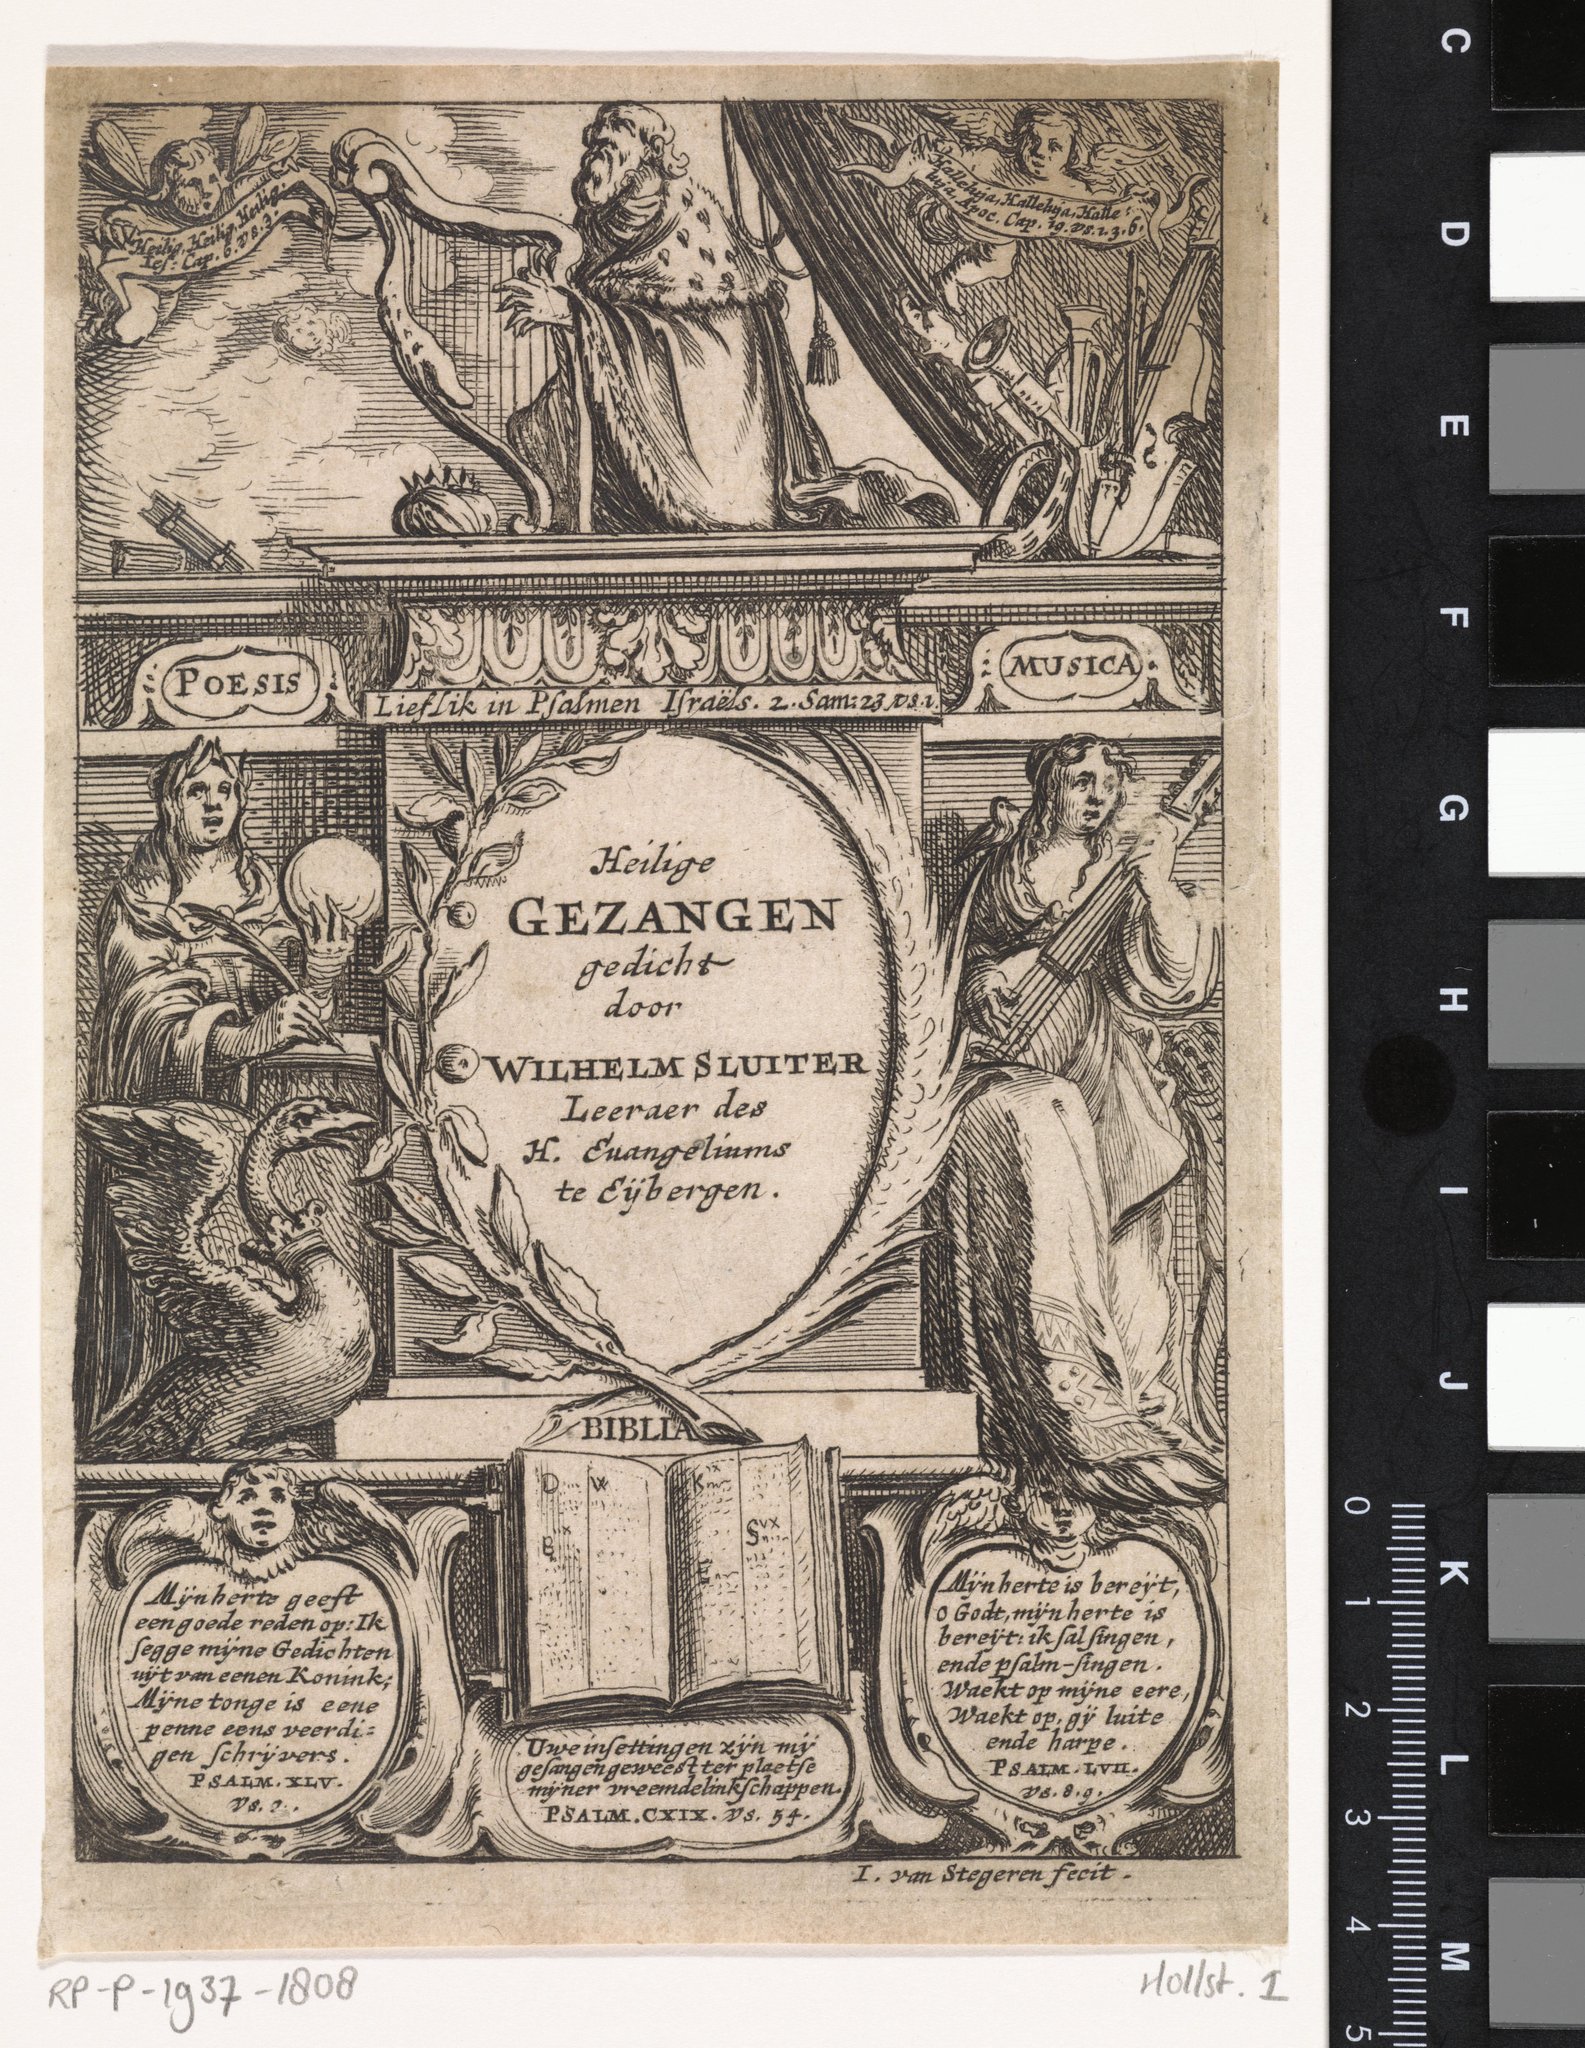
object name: titelblad, titelpagina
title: Allegorische voorstelling op de psalmen en geestelijke liederen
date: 1661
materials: paper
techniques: engraving, etching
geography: deventer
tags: cherubs, i.e. children's heads with wings, 'musica', symbolic representations, allegories and emblems ~ music; 'musica'(ripa), david as psalmist, as author of the psalms, usually playing the harp, symbolic representations, allegories and emblems ~ poetry; 'poesia' (ripa)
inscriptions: collector's mark: Lugt 2228, collector's mark: Lugt 2760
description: Een monument met de titel van het boek van Willem Sluiter wordt geflankeerd door de personificatie van de Dichtkunst, met schrijfveer in de hand, en de Muziek, met een luit. Bovenaan bespeelt koning David, de schrijver van de psalmen, de harp. Zijn kroon staat naast hem. Onderaan een opengeslagen bijbel en drie cartouches met teksten uit psalmen.